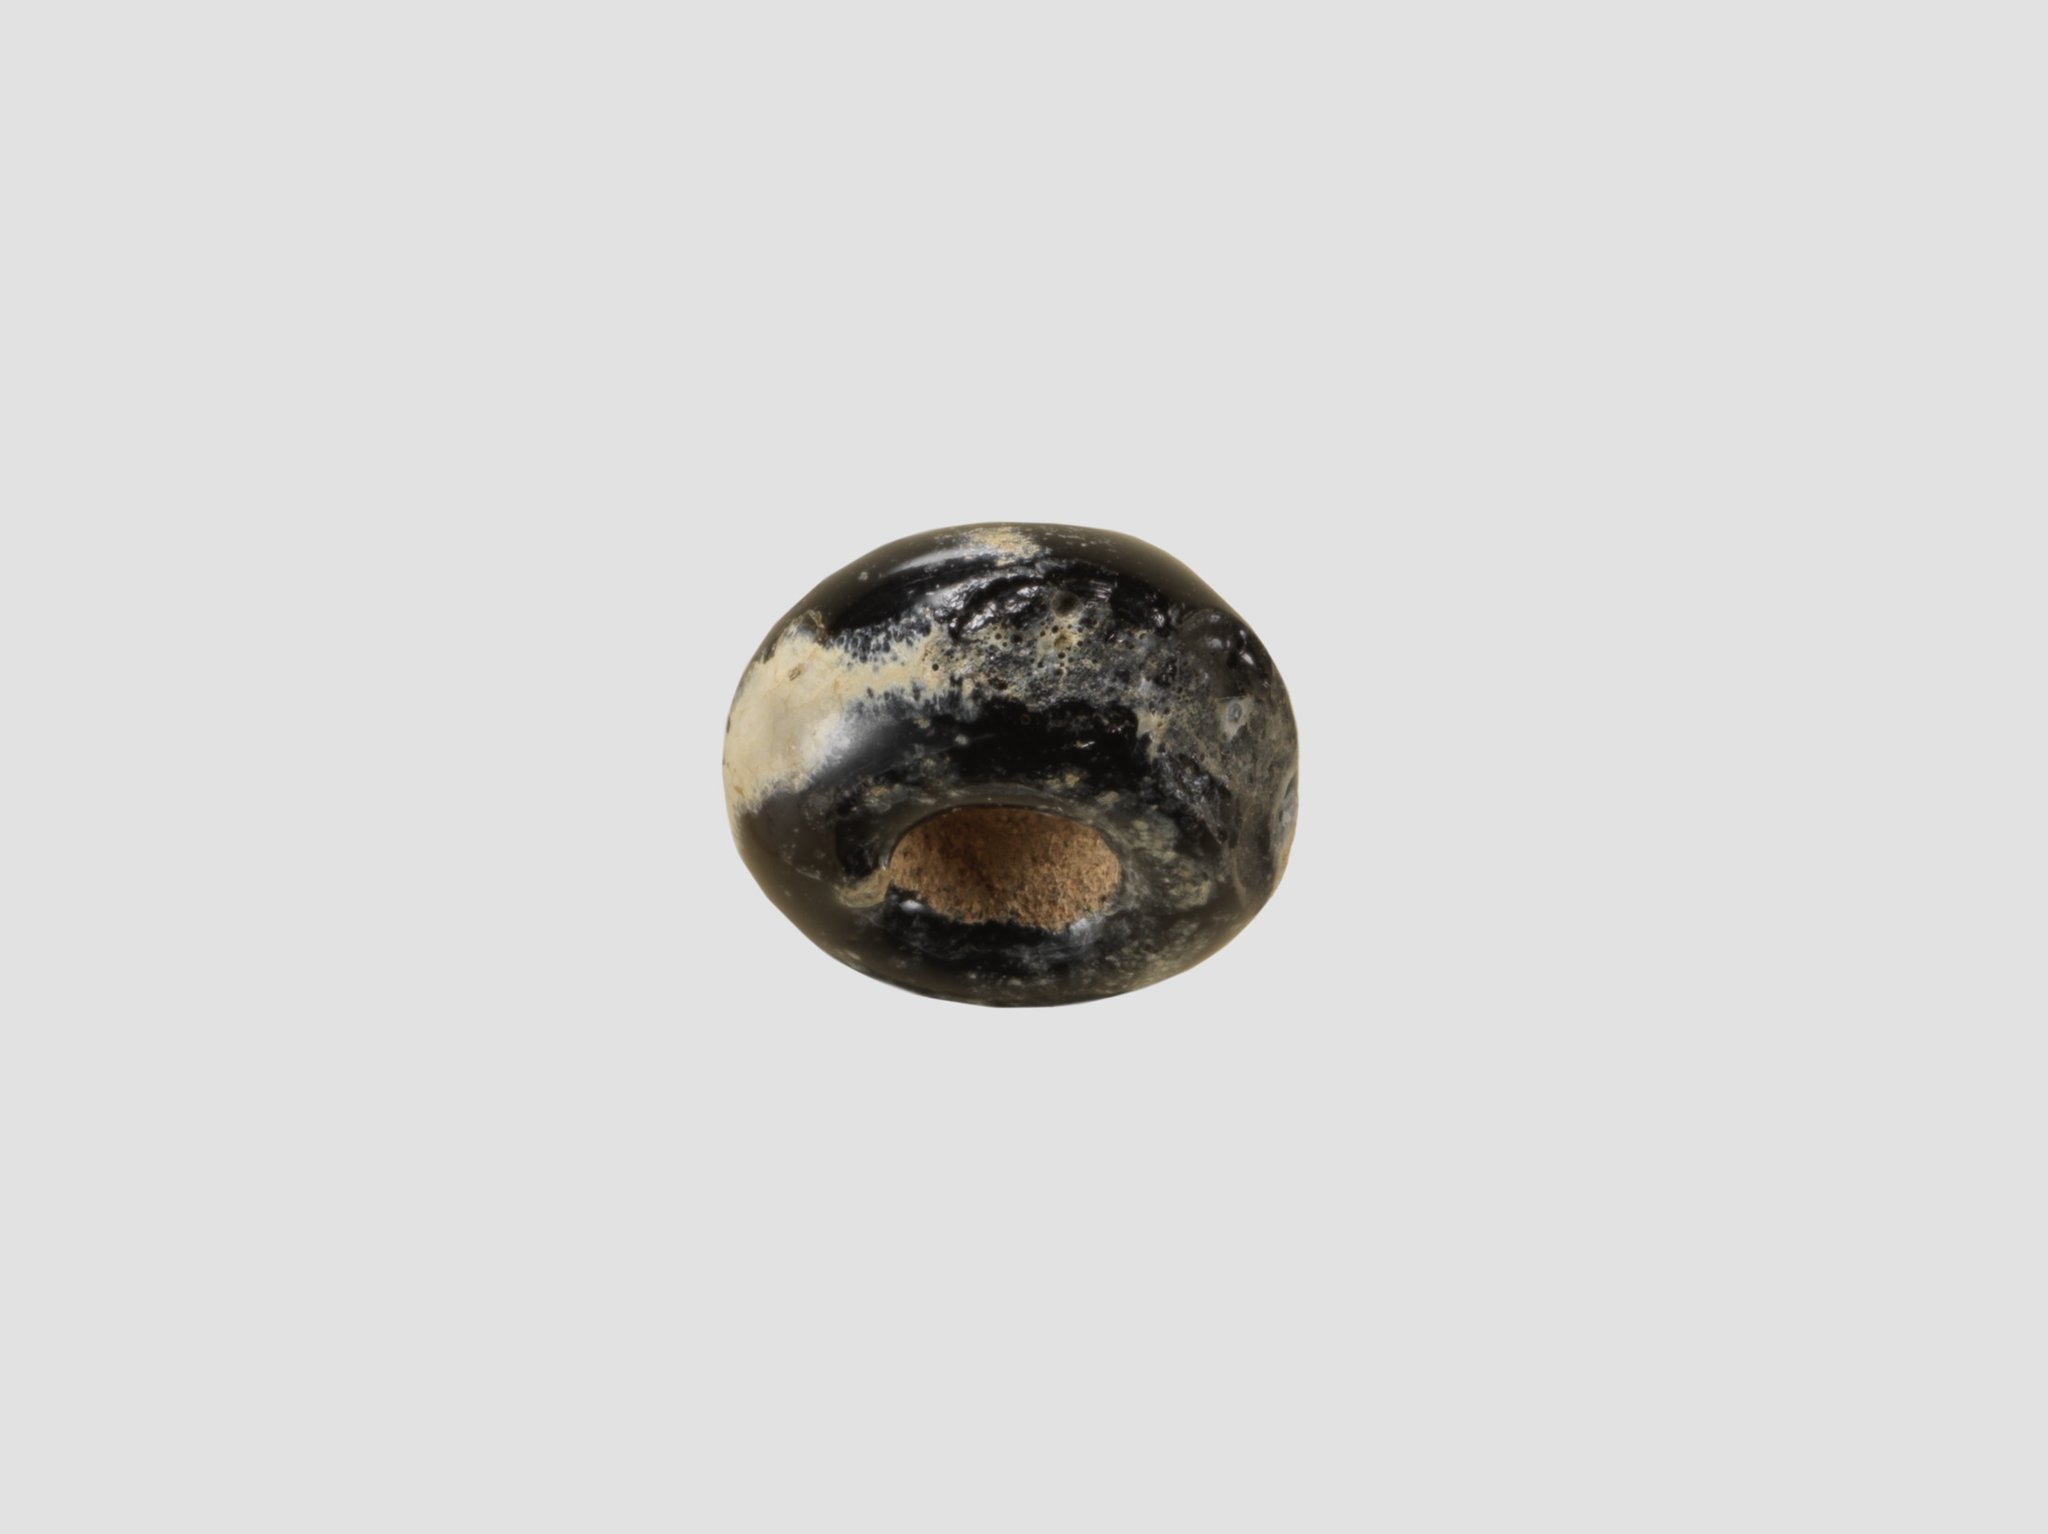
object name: bead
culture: parthian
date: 1-100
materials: glass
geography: iran